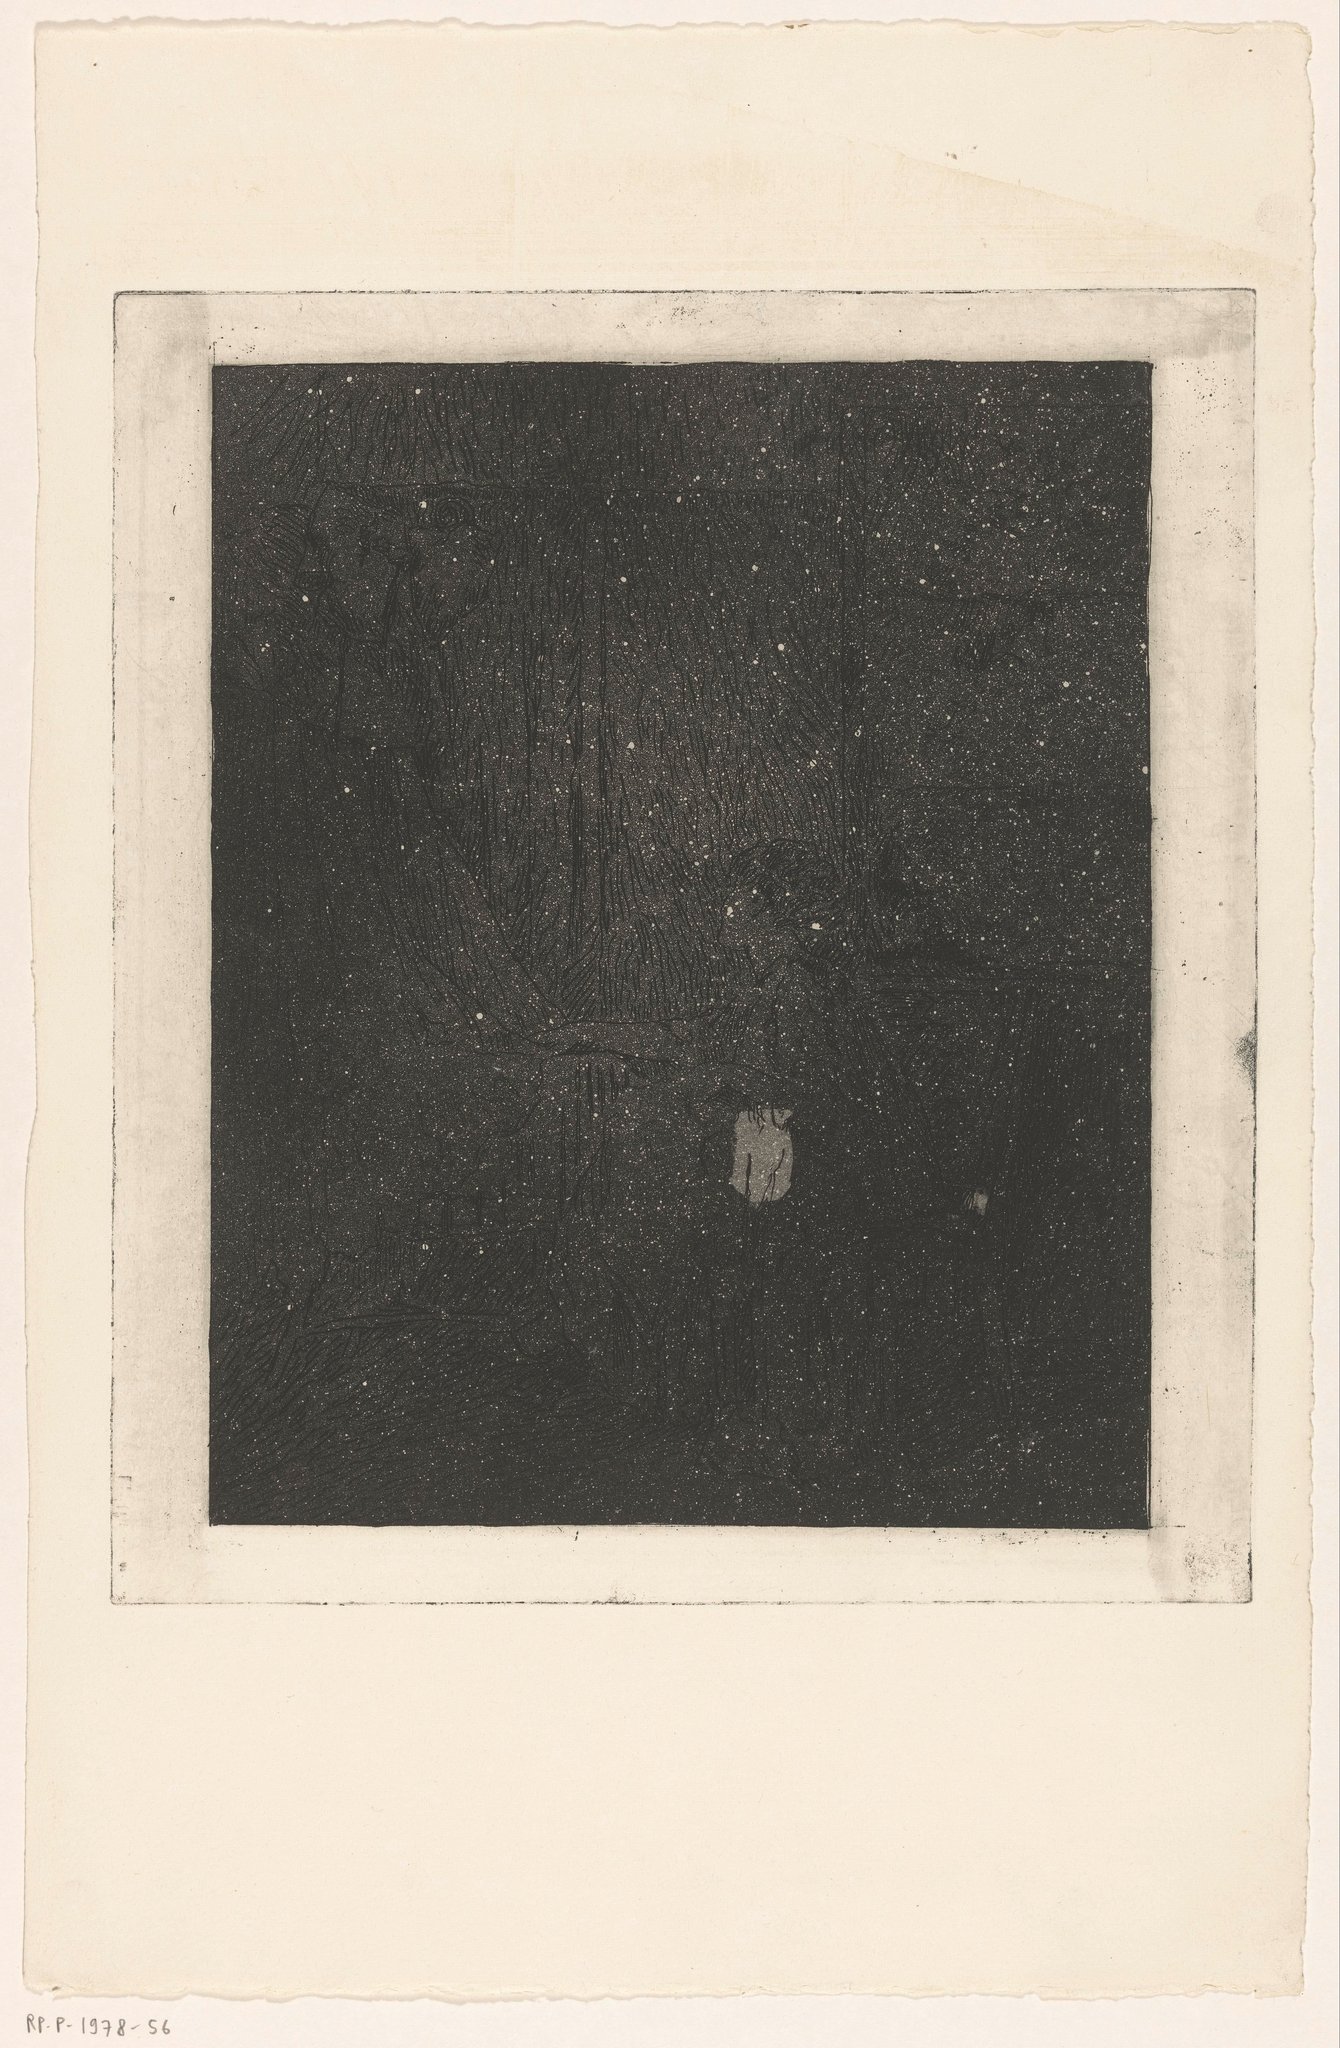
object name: print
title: Vrouw die op een stoel naast een wieg zit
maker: albert roelofs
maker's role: print maker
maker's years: 1877-1920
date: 1887-1920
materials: paper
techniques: aquatint, etching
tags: cradle, crib, mother and child(ren), woman and child(ren) (family group)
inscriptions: number: ‘1219 / 21’, collector's mark: Lugt 2228, collector's mark: Lugt 2760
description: De vrouw leunt met haar arm op de rand van de wieg.